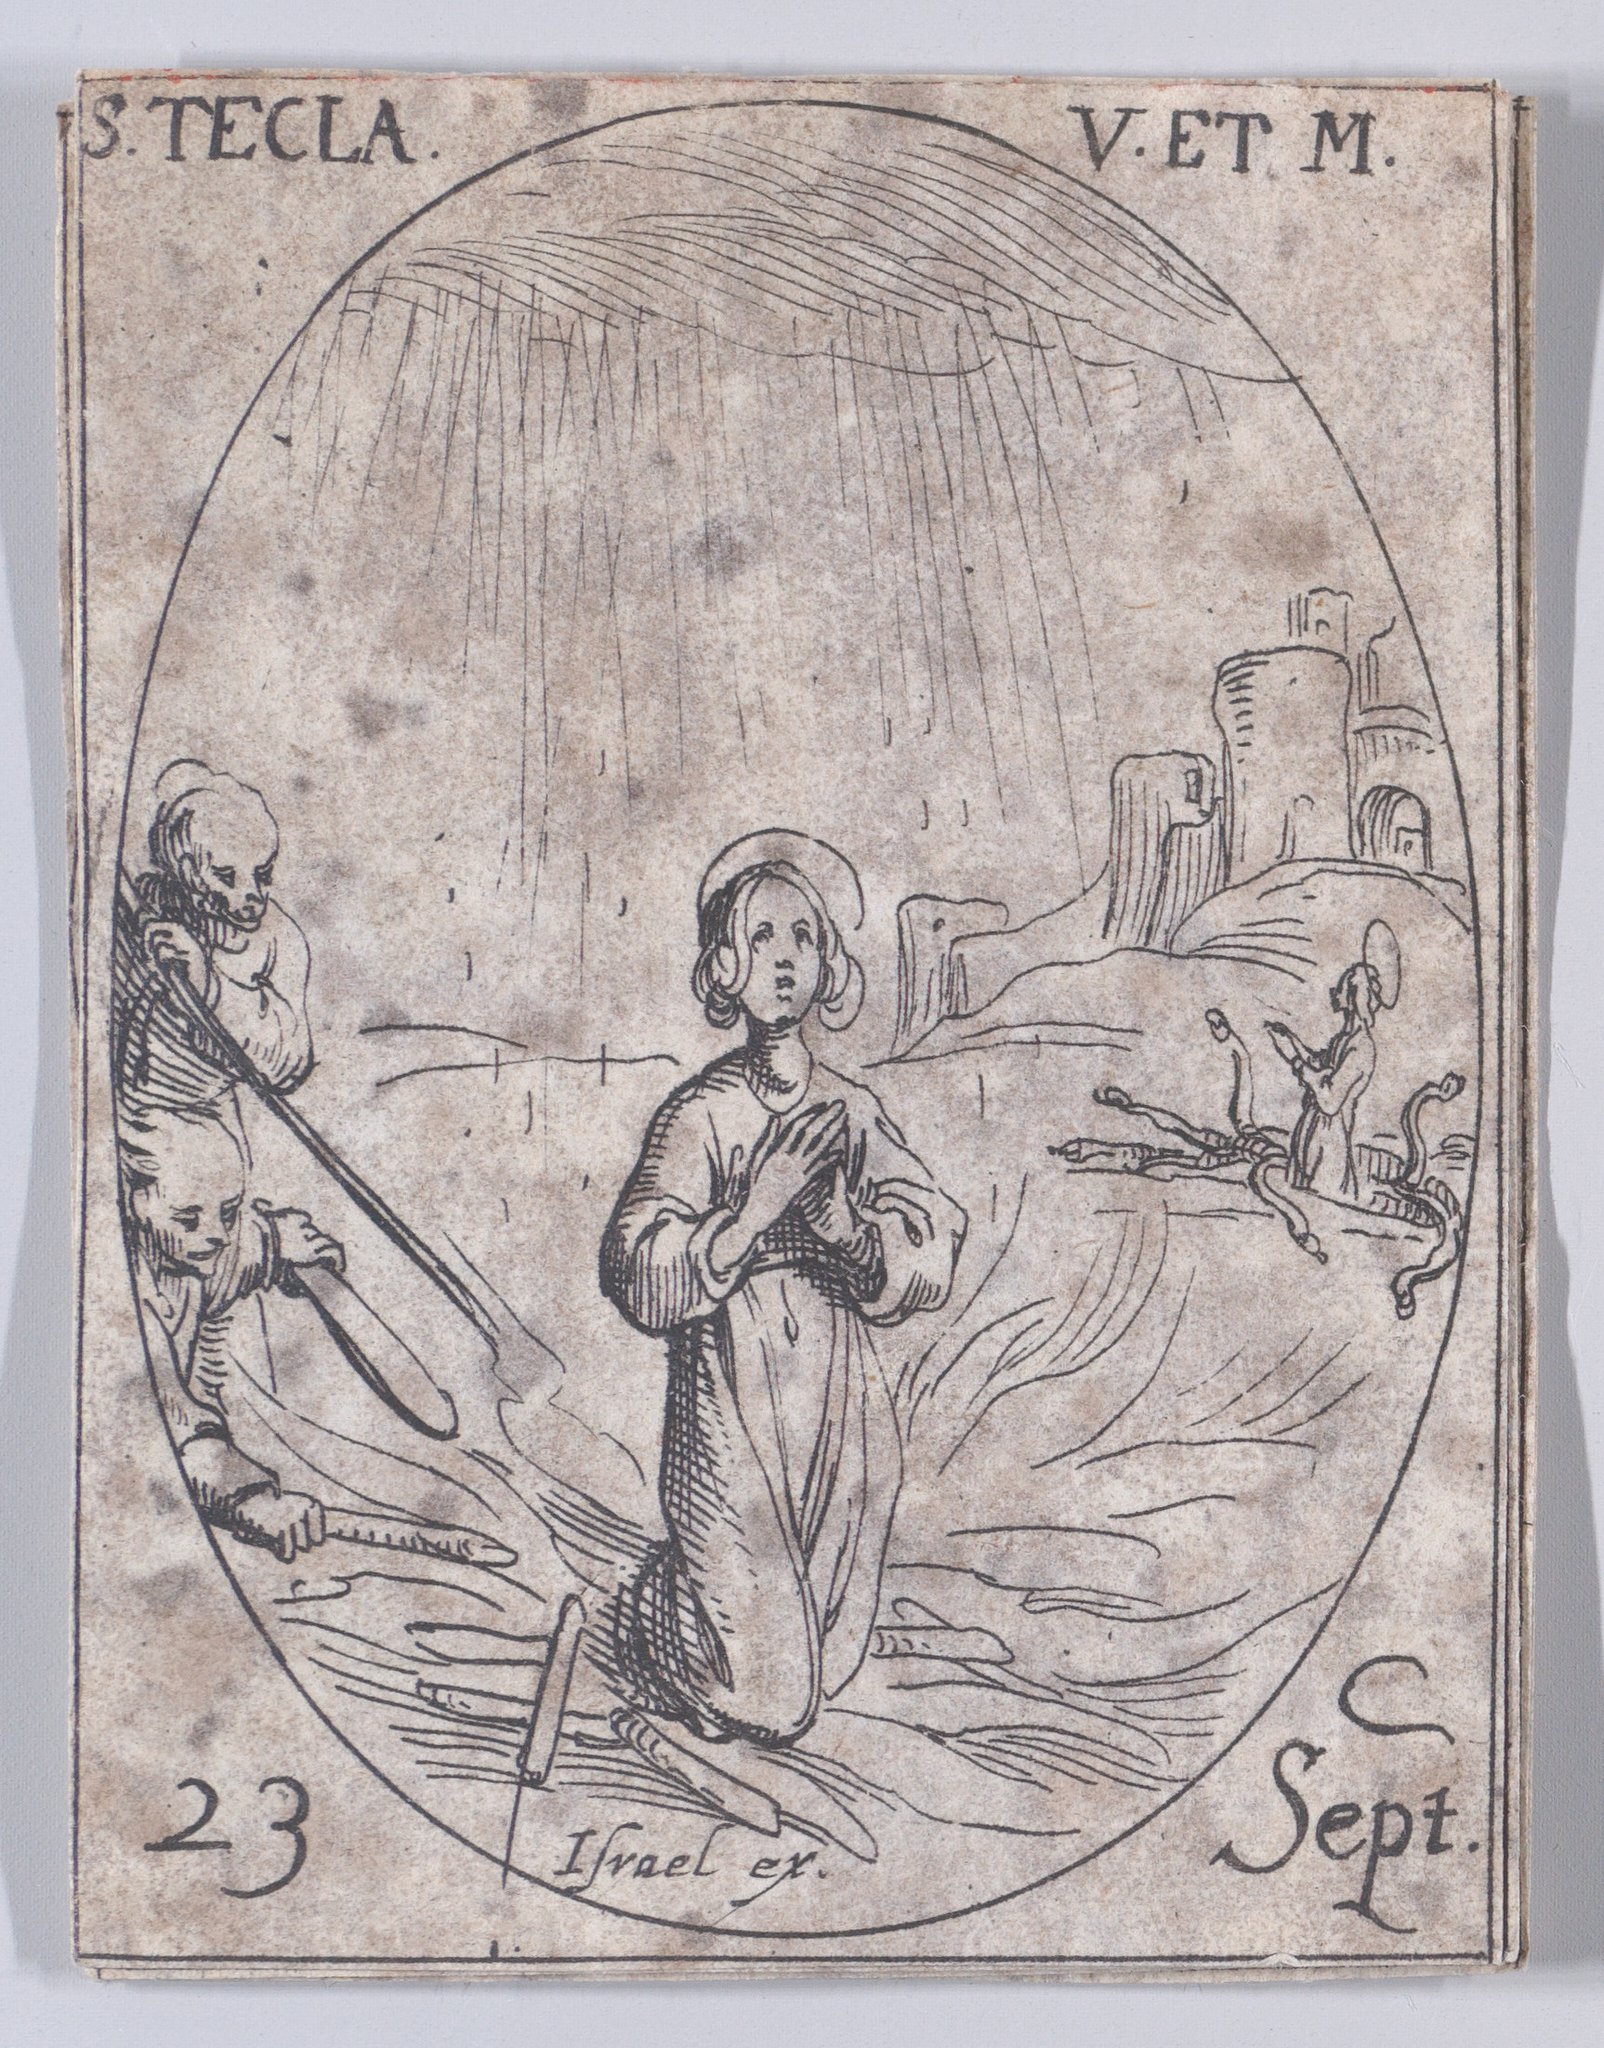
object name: print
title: Ste. Thècle, vierge et martyre (St. Thecla, Virgin and Martyr), September 23rd, from "Les Images De Tous Les Saincts et Saintes de L'Année" (Images of All of the Saints and Religious Events of the Year)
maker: jacques callot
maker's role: artist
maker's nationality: french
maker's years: 1592-1635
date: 1636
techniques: etching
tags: women,saints